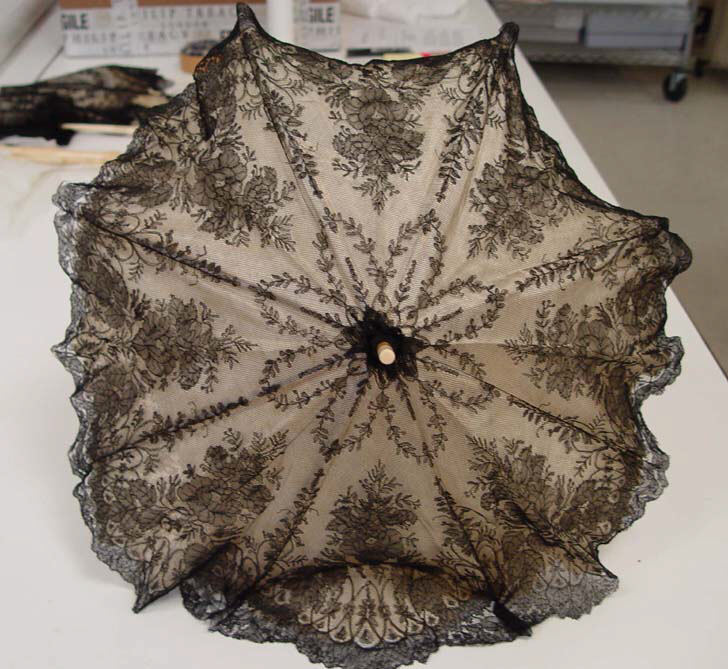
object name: parasol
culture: american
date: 1855-1870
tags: flowers